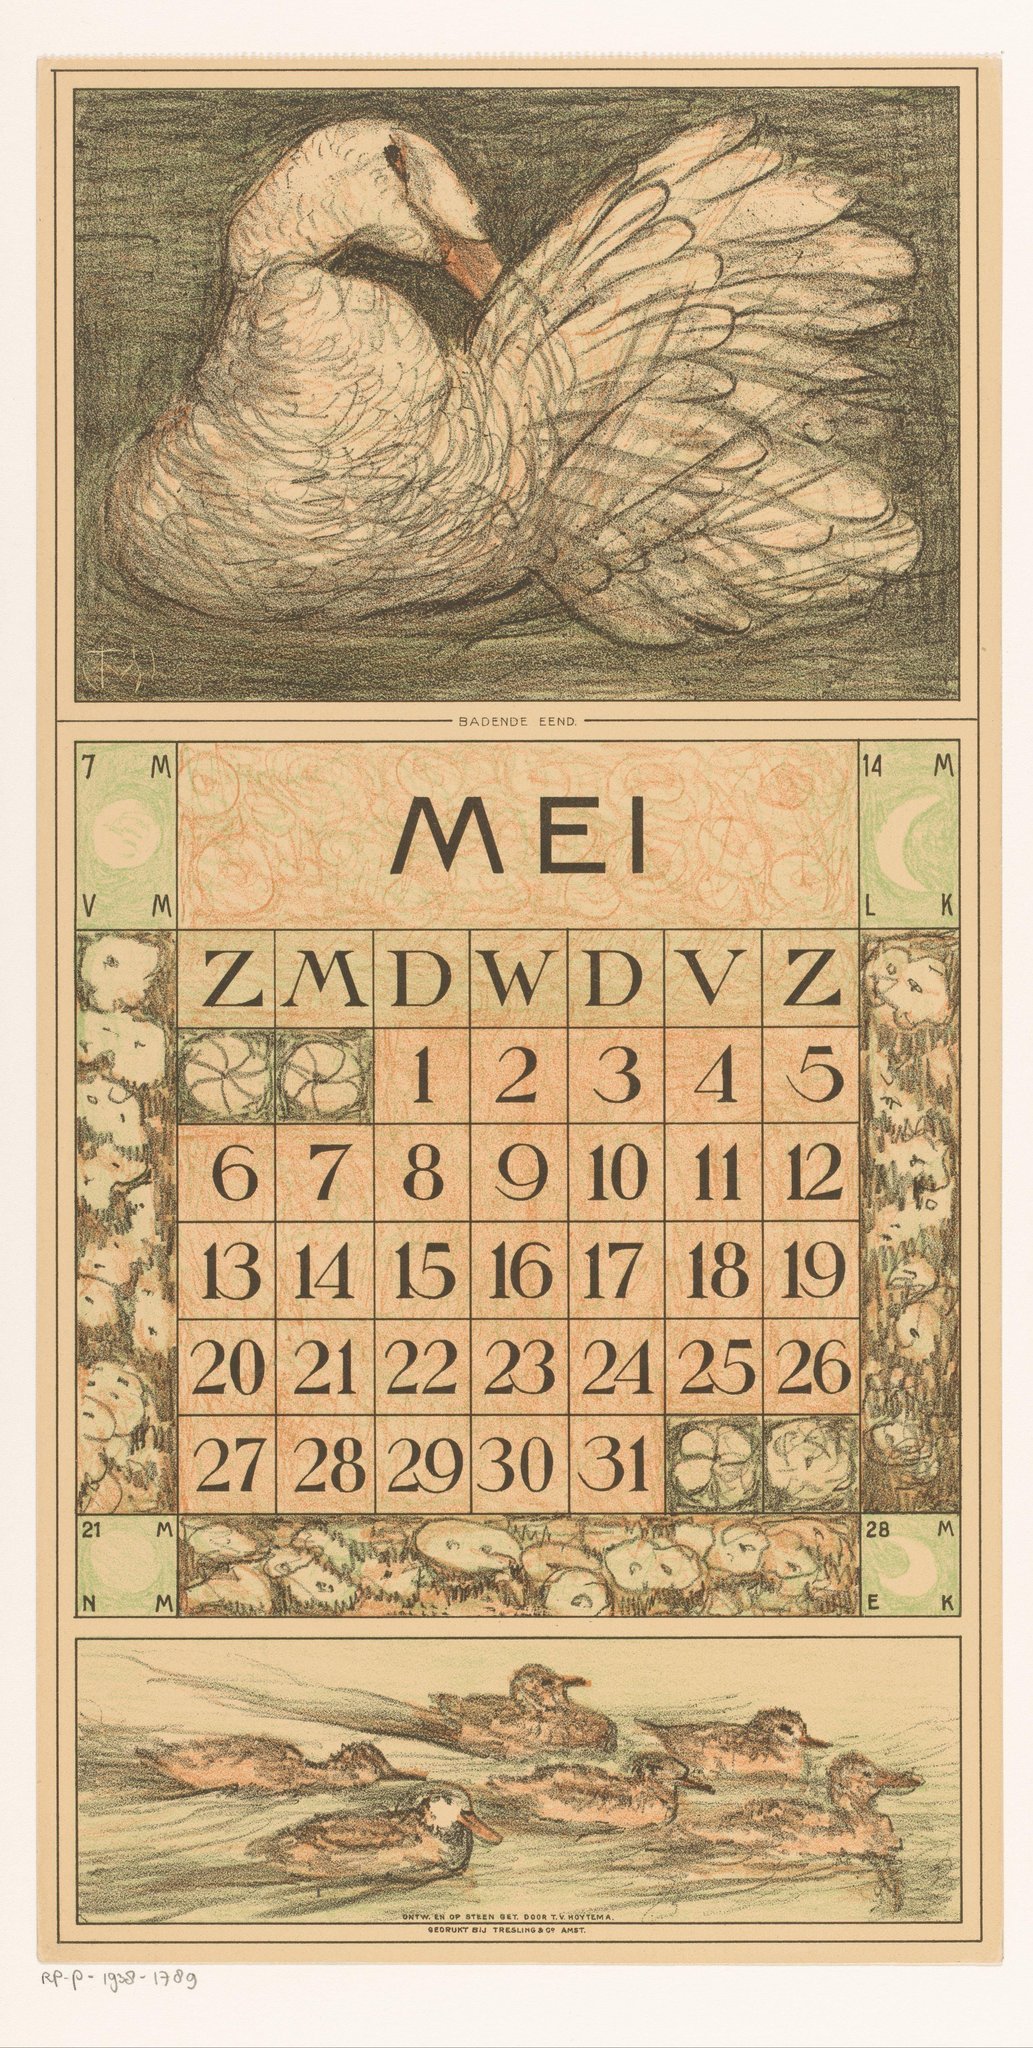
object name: calendar leaf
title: Kalender 1917 12 lithografien door Th. v. Hoytema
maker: theo van hoytema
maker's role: draughtsman, painter, print maker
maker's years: 1863-1917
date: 1916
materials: paper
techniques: lithograph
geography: amsterdam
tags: lunar year, water-birds: duck, may ~ other concepts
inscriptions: collector's mark: Lugt 2228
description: De eend wast zichzelf. Onderin zwemmende eendenjongen. In de hoeken de standen van de maan op vier dagen. Bovenaan het blad een scheurlijn.